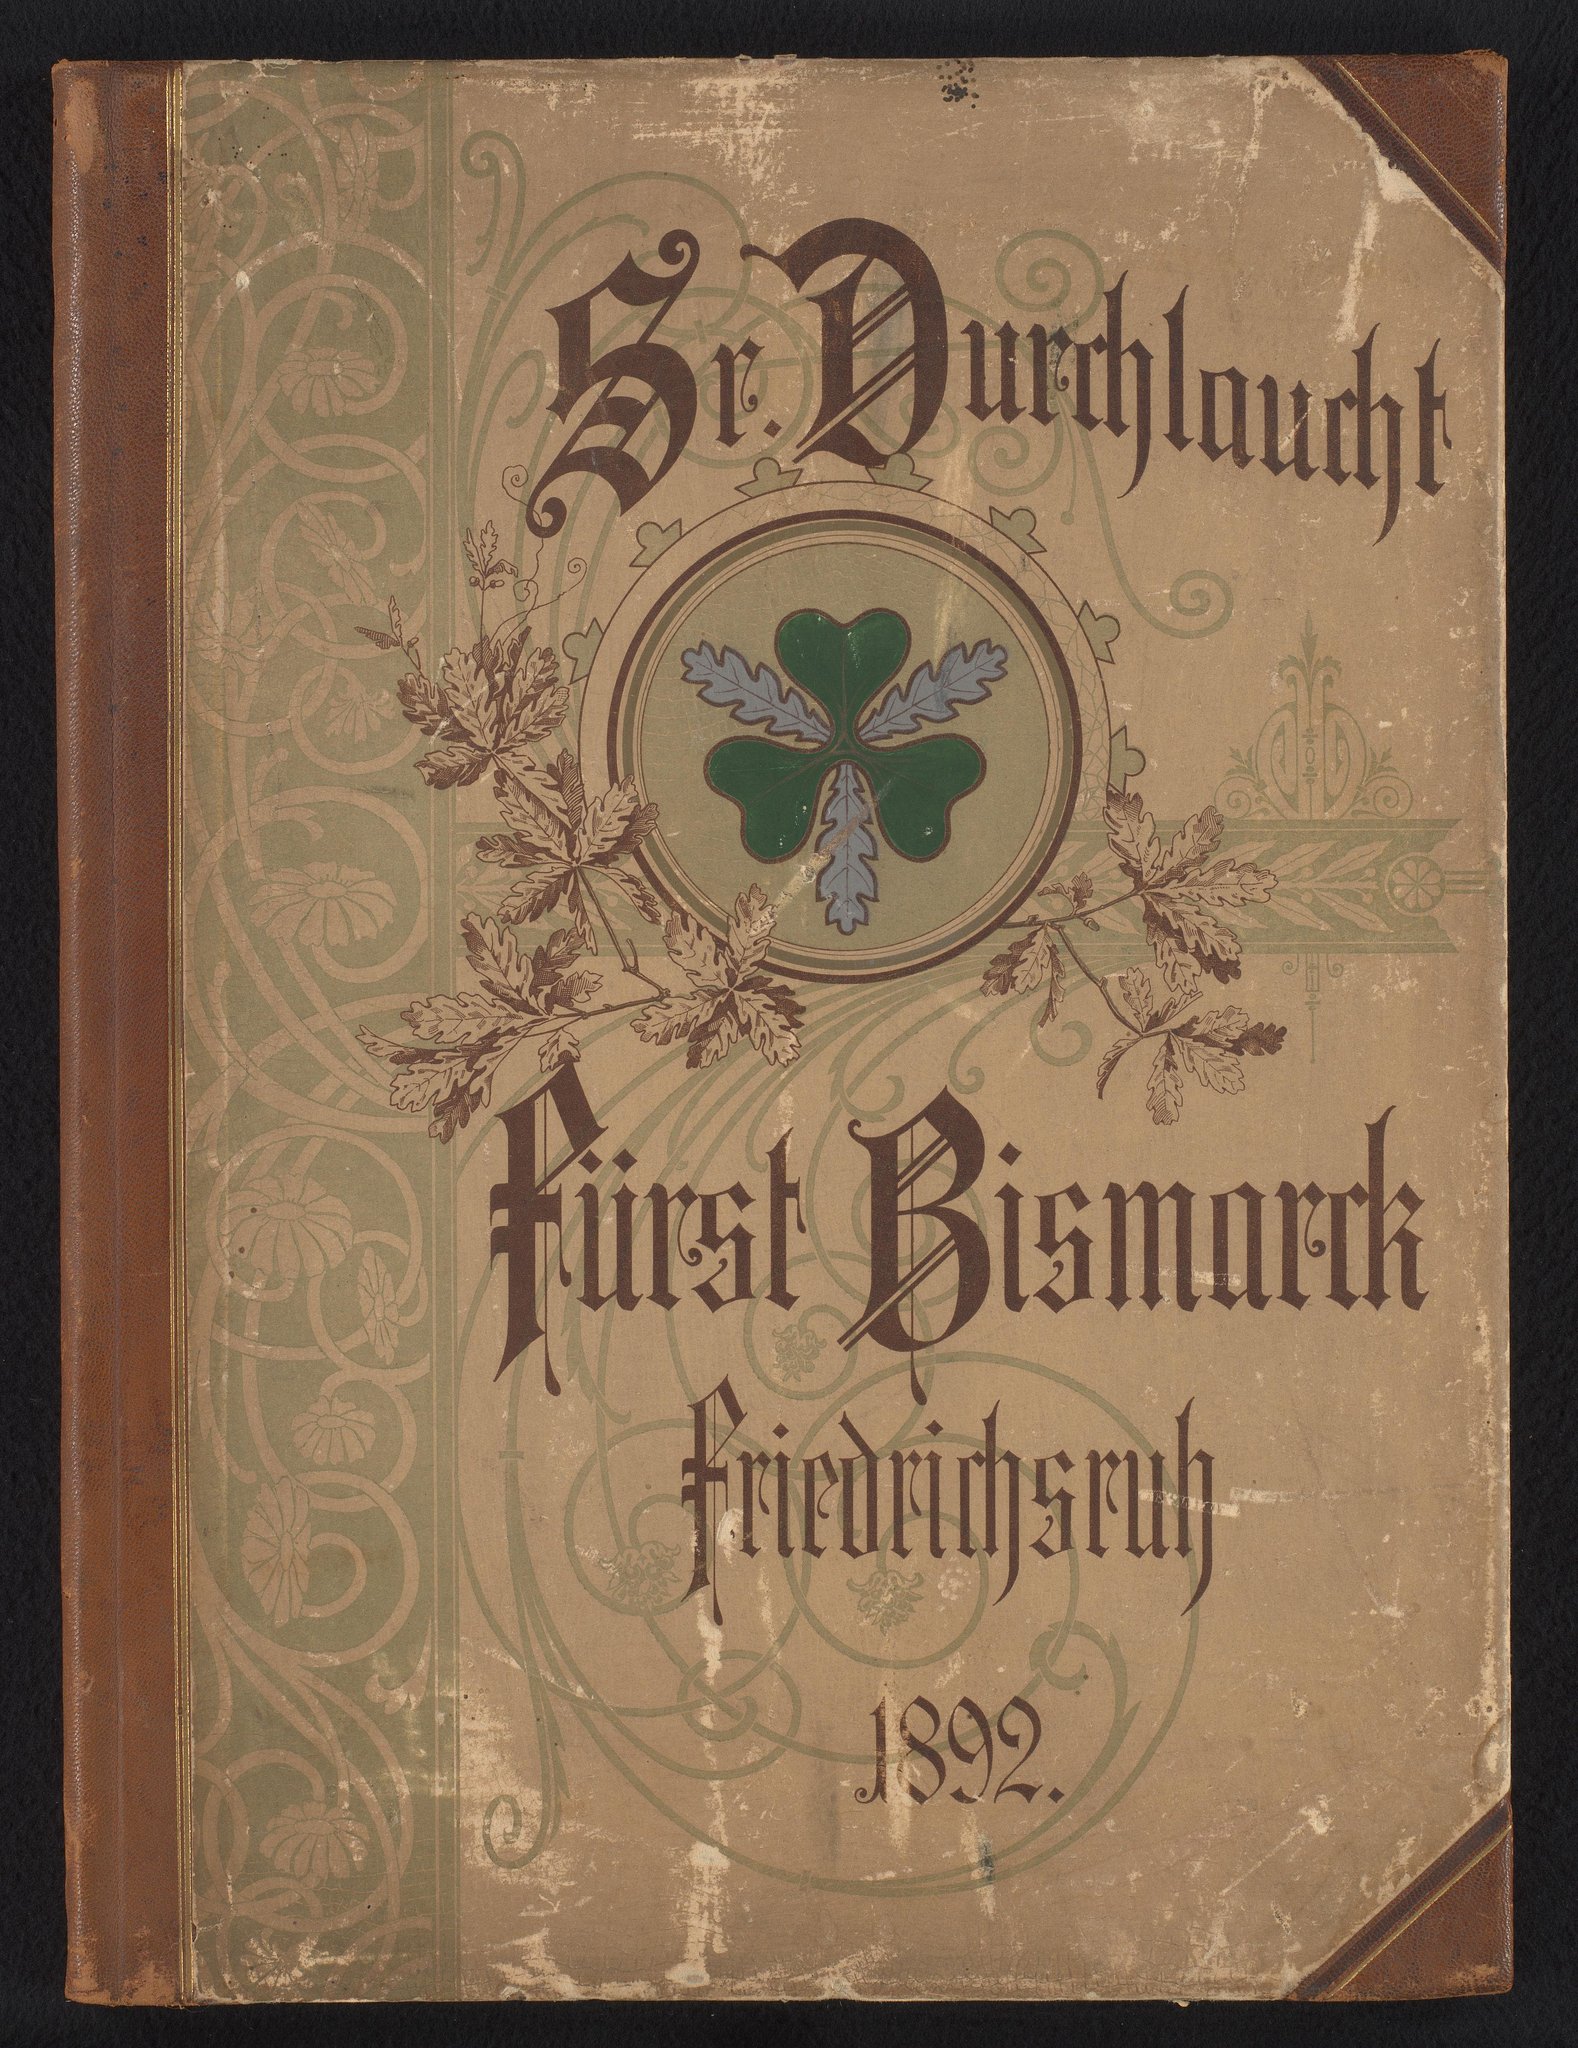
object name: book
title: Die Deutsche Kaiser-Hackmaschine (...)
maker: Anonymous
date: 1897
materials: paper, cardboard, leather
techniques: gelatin silver print, letterpress printing, line block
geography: magdeburg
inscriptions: date: ‘NOV 2017’